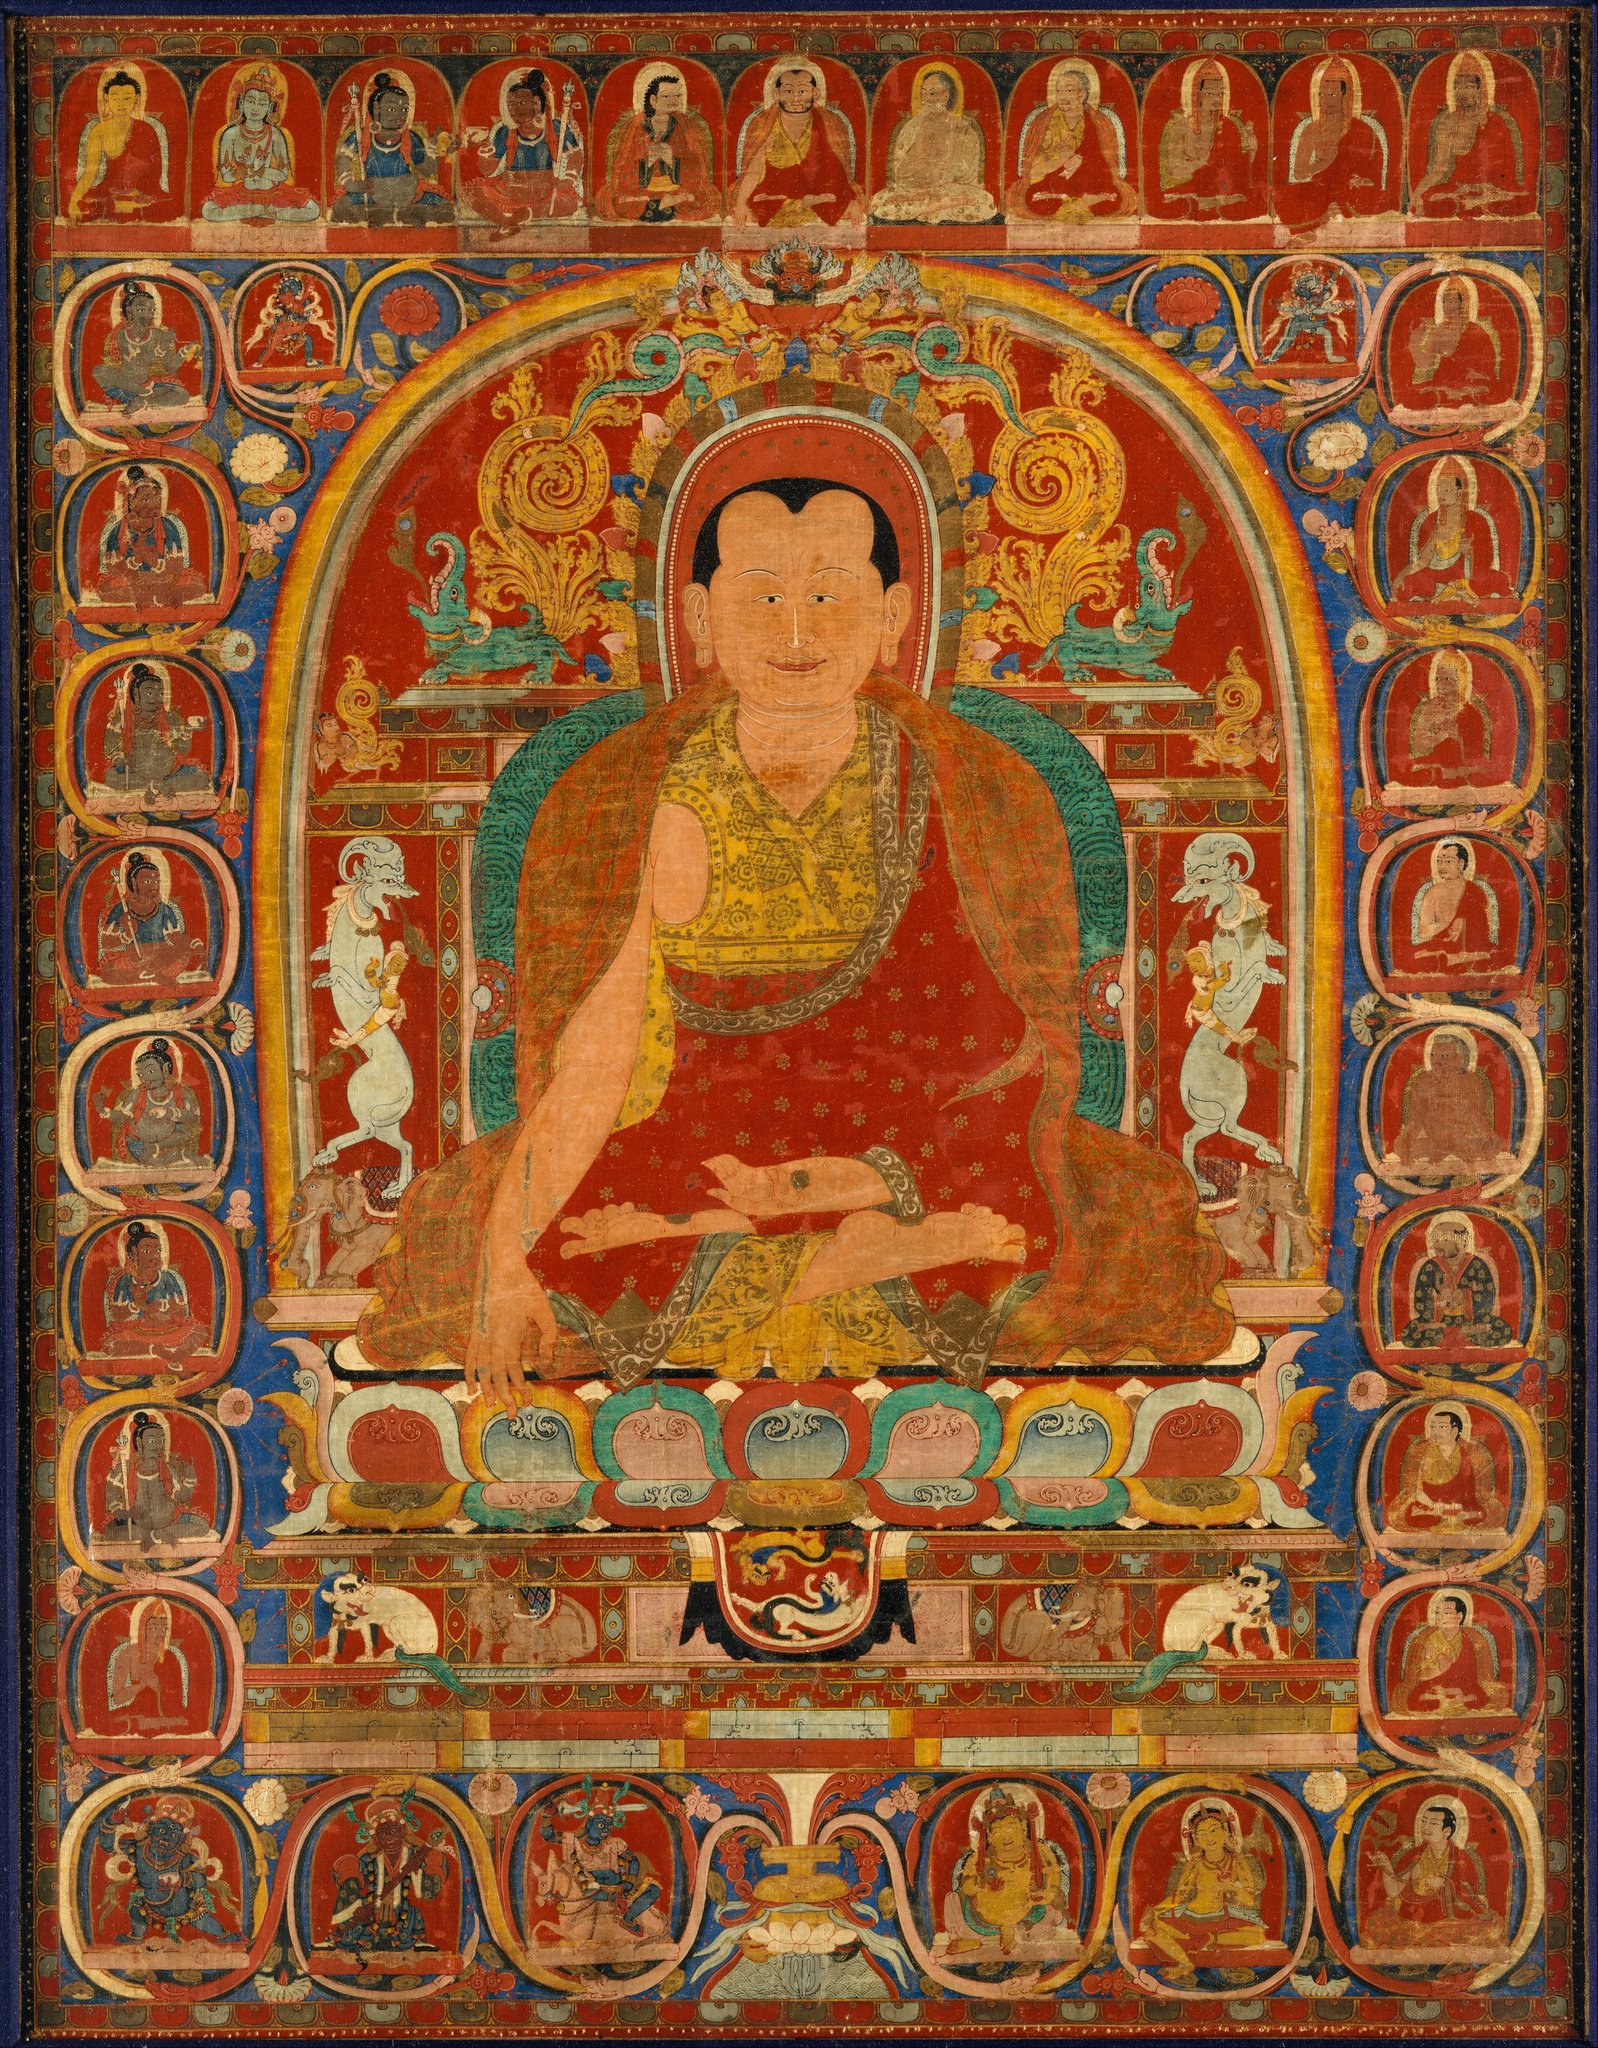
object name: painting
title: Lineage Portrait of an Abbot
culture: tibetan, central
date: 1350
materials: textile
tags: men,portraits,mythical creatures,elephants,buddhism